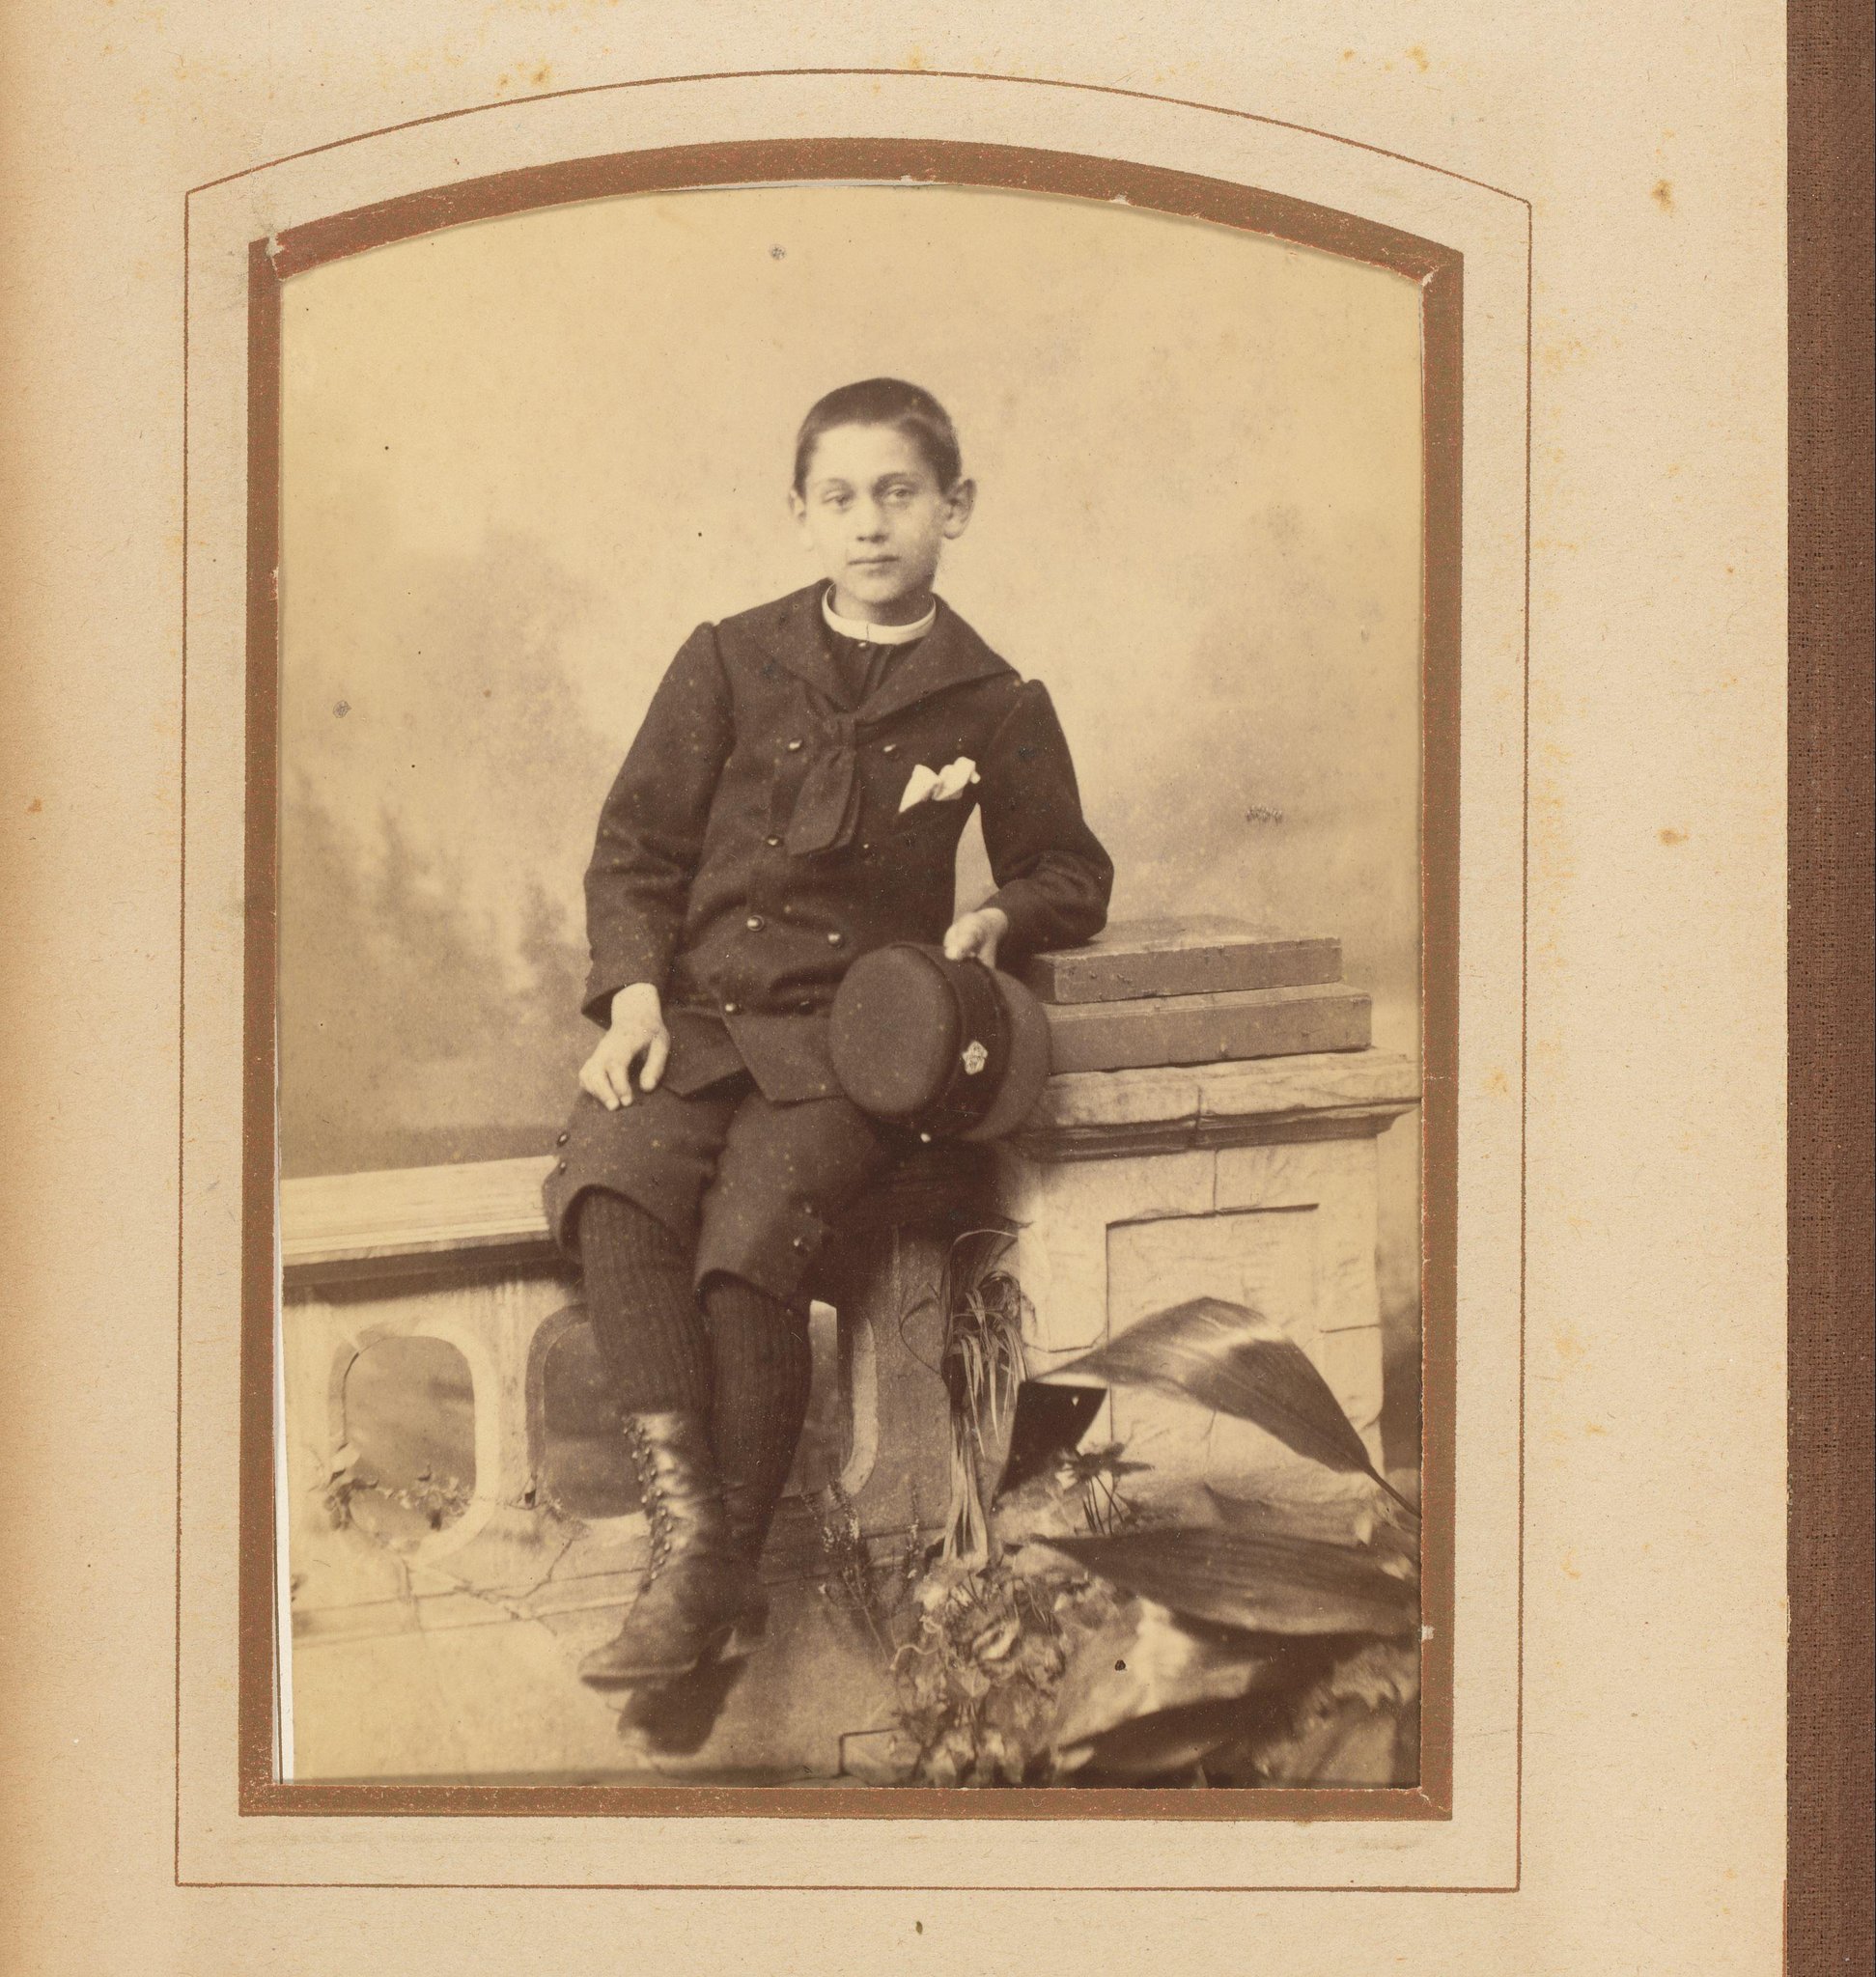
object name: cabinet photograph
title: Portret van een jongen met pet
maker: Anonymous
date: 1860-1900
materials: cardboard, photographic support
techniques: albumen print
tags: boy (child between toddler and youth), head-gear: cap